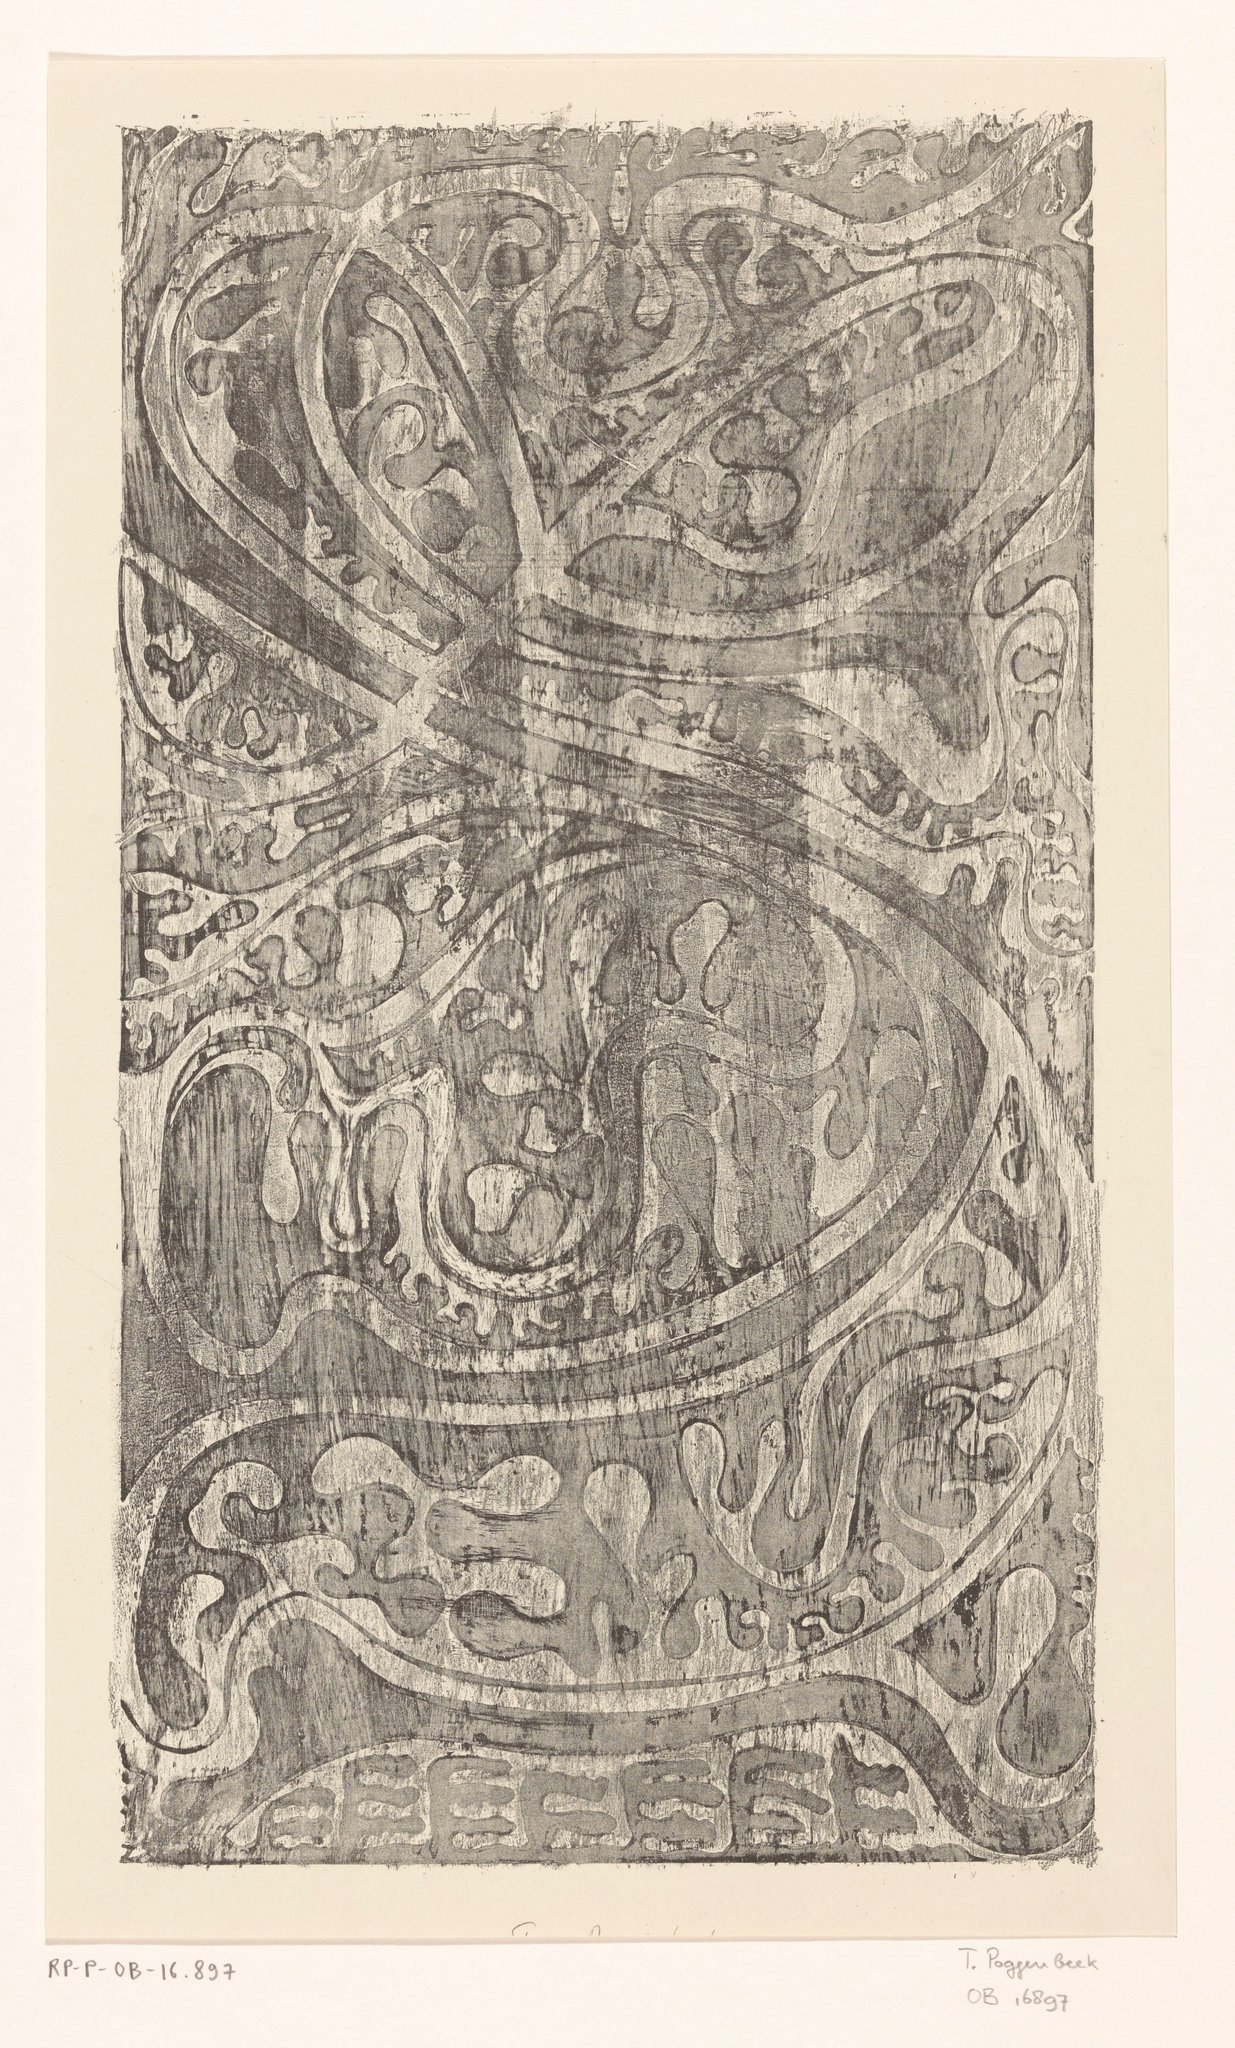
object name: print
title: Slingerende plantmotieven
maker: tom poggenbeek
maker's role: print maker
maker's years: 1872-1942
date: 1882-1942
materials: paper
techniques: lithograph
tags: ornament derived from plant forms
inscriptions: collector's mark: Lugt 2233